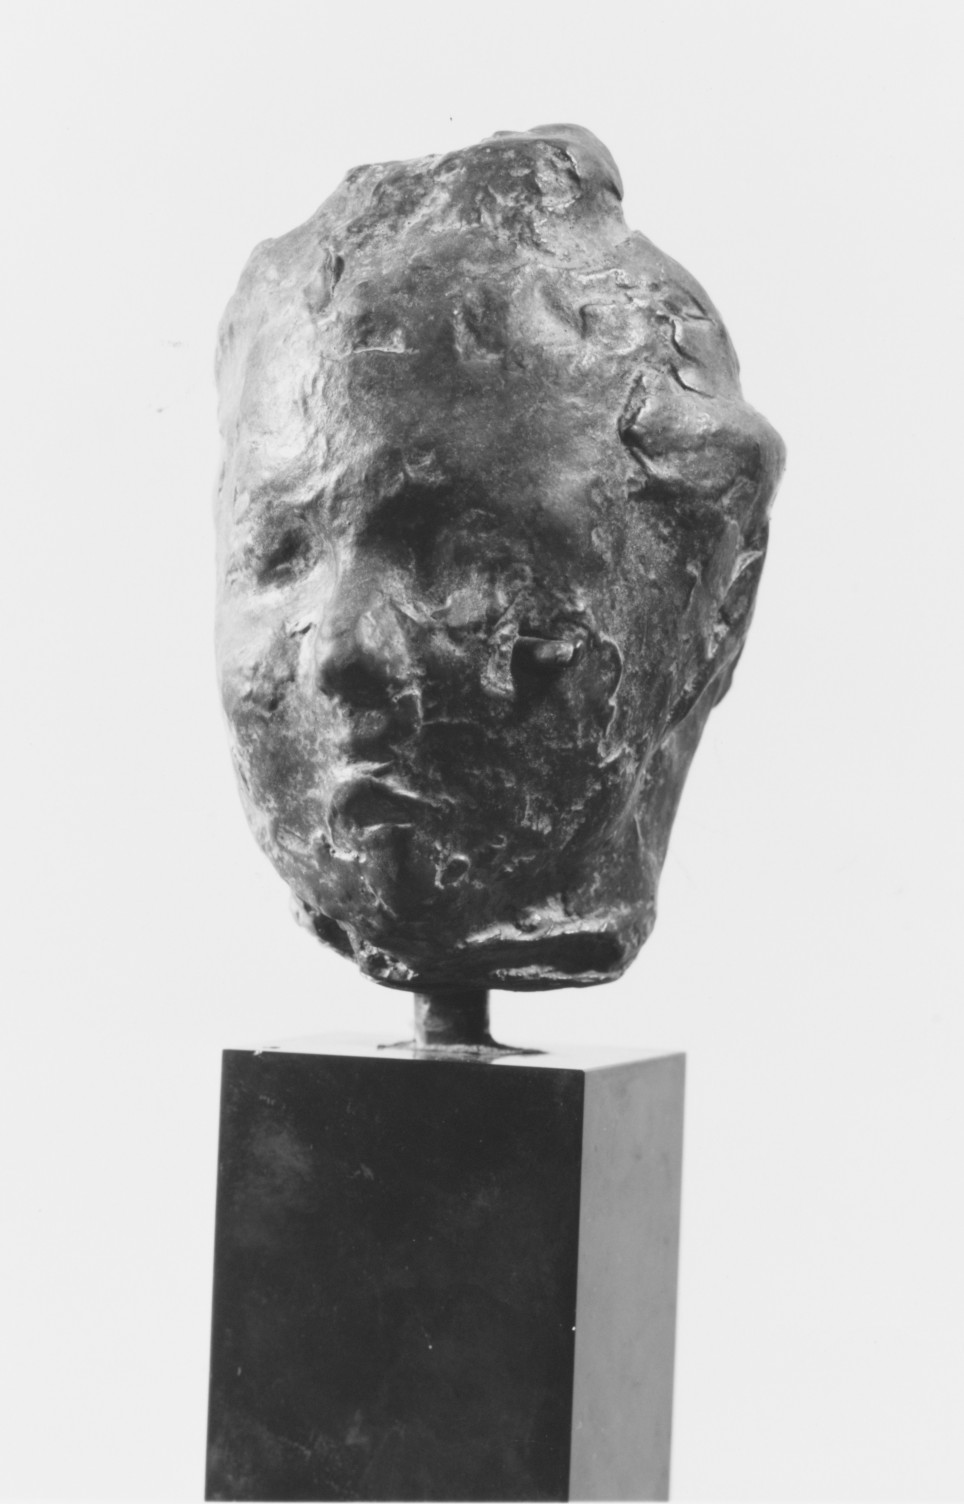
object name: head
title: Study for a Portrait of Mathilde Salle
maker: edgar degas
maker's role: artist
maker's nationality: french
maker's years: 1834-1917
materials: bronze, marble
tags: heads,portraits